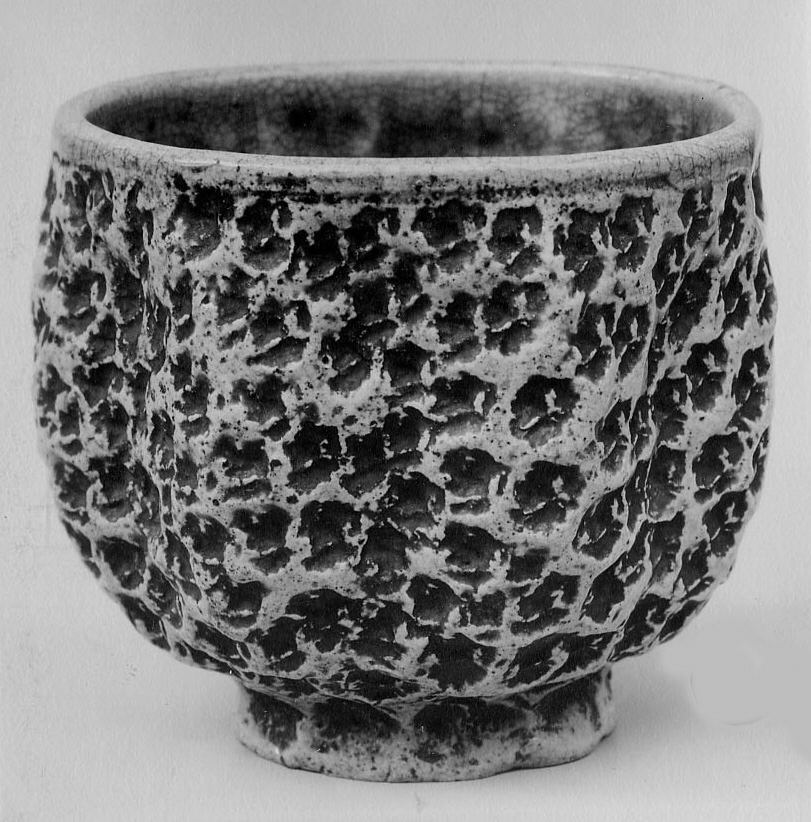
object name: teabowl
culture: japanese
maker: amano kaneshige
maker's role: artist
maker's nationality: japanese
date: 1860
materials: clay, glaze